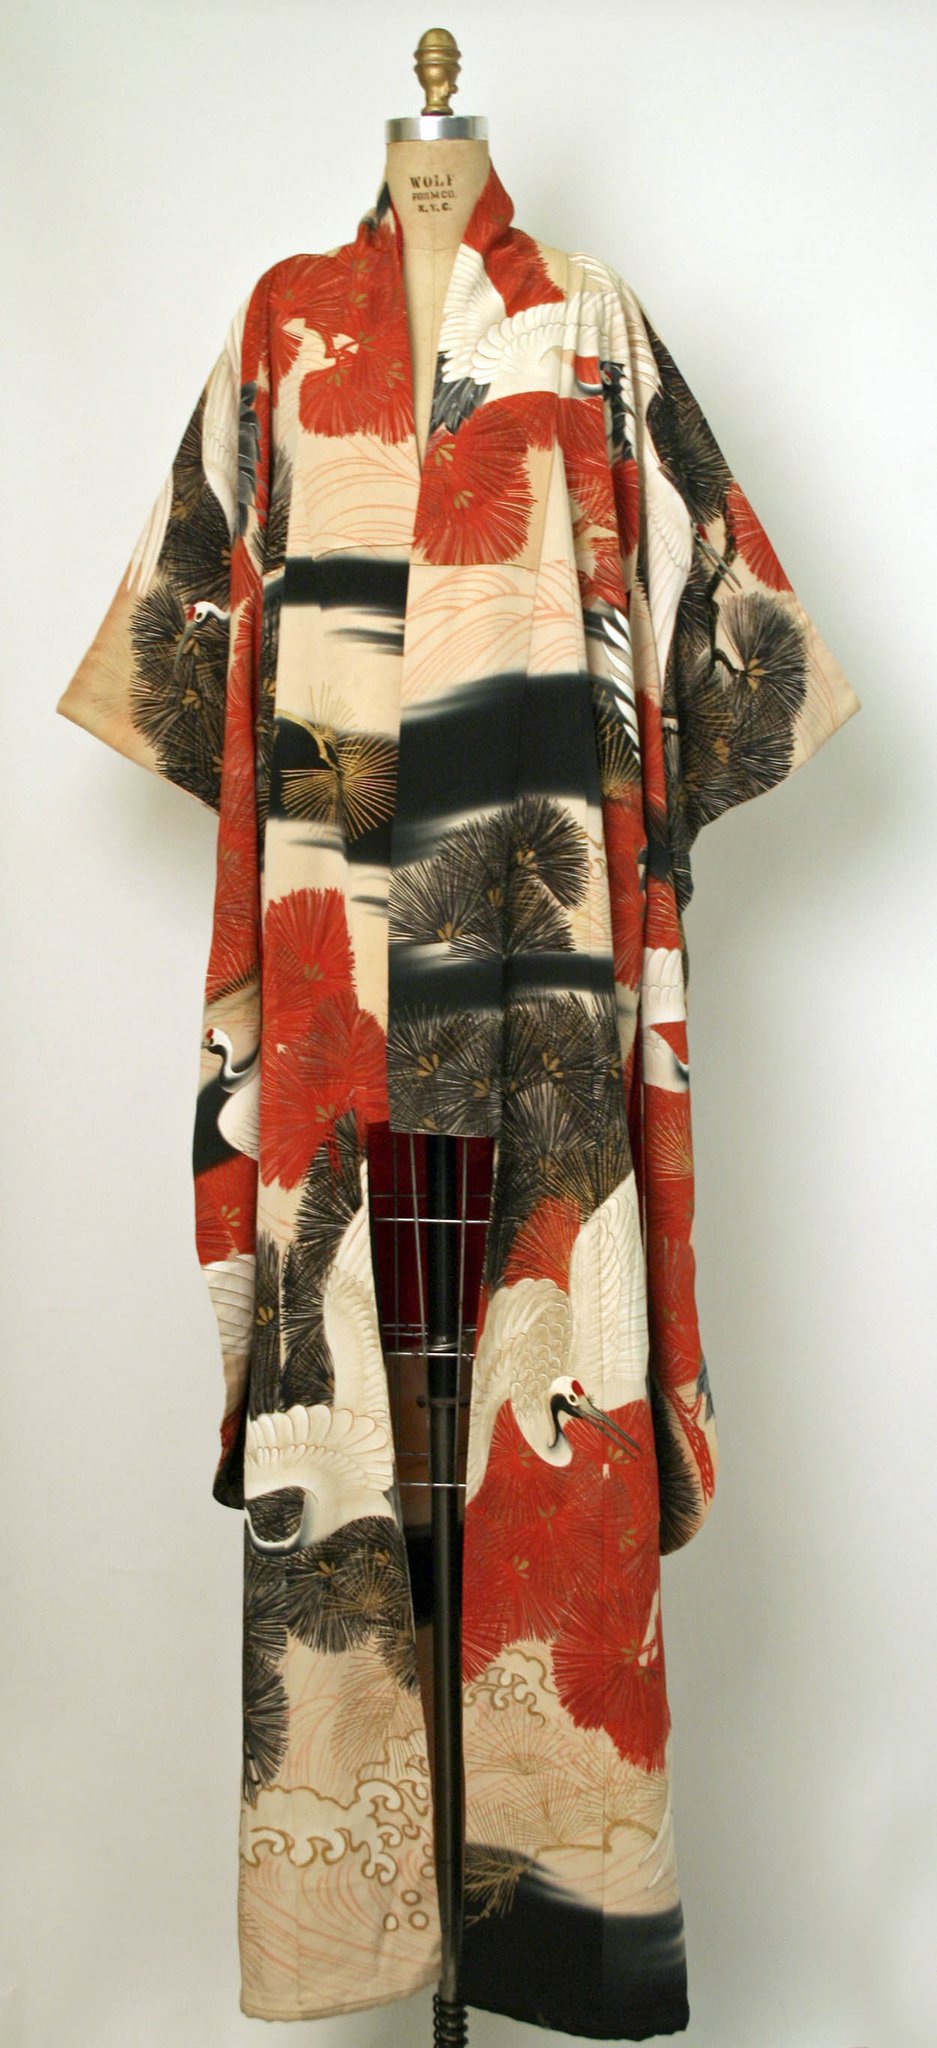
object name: furisode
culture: japanese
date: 1850-1950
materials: silk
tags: cranes